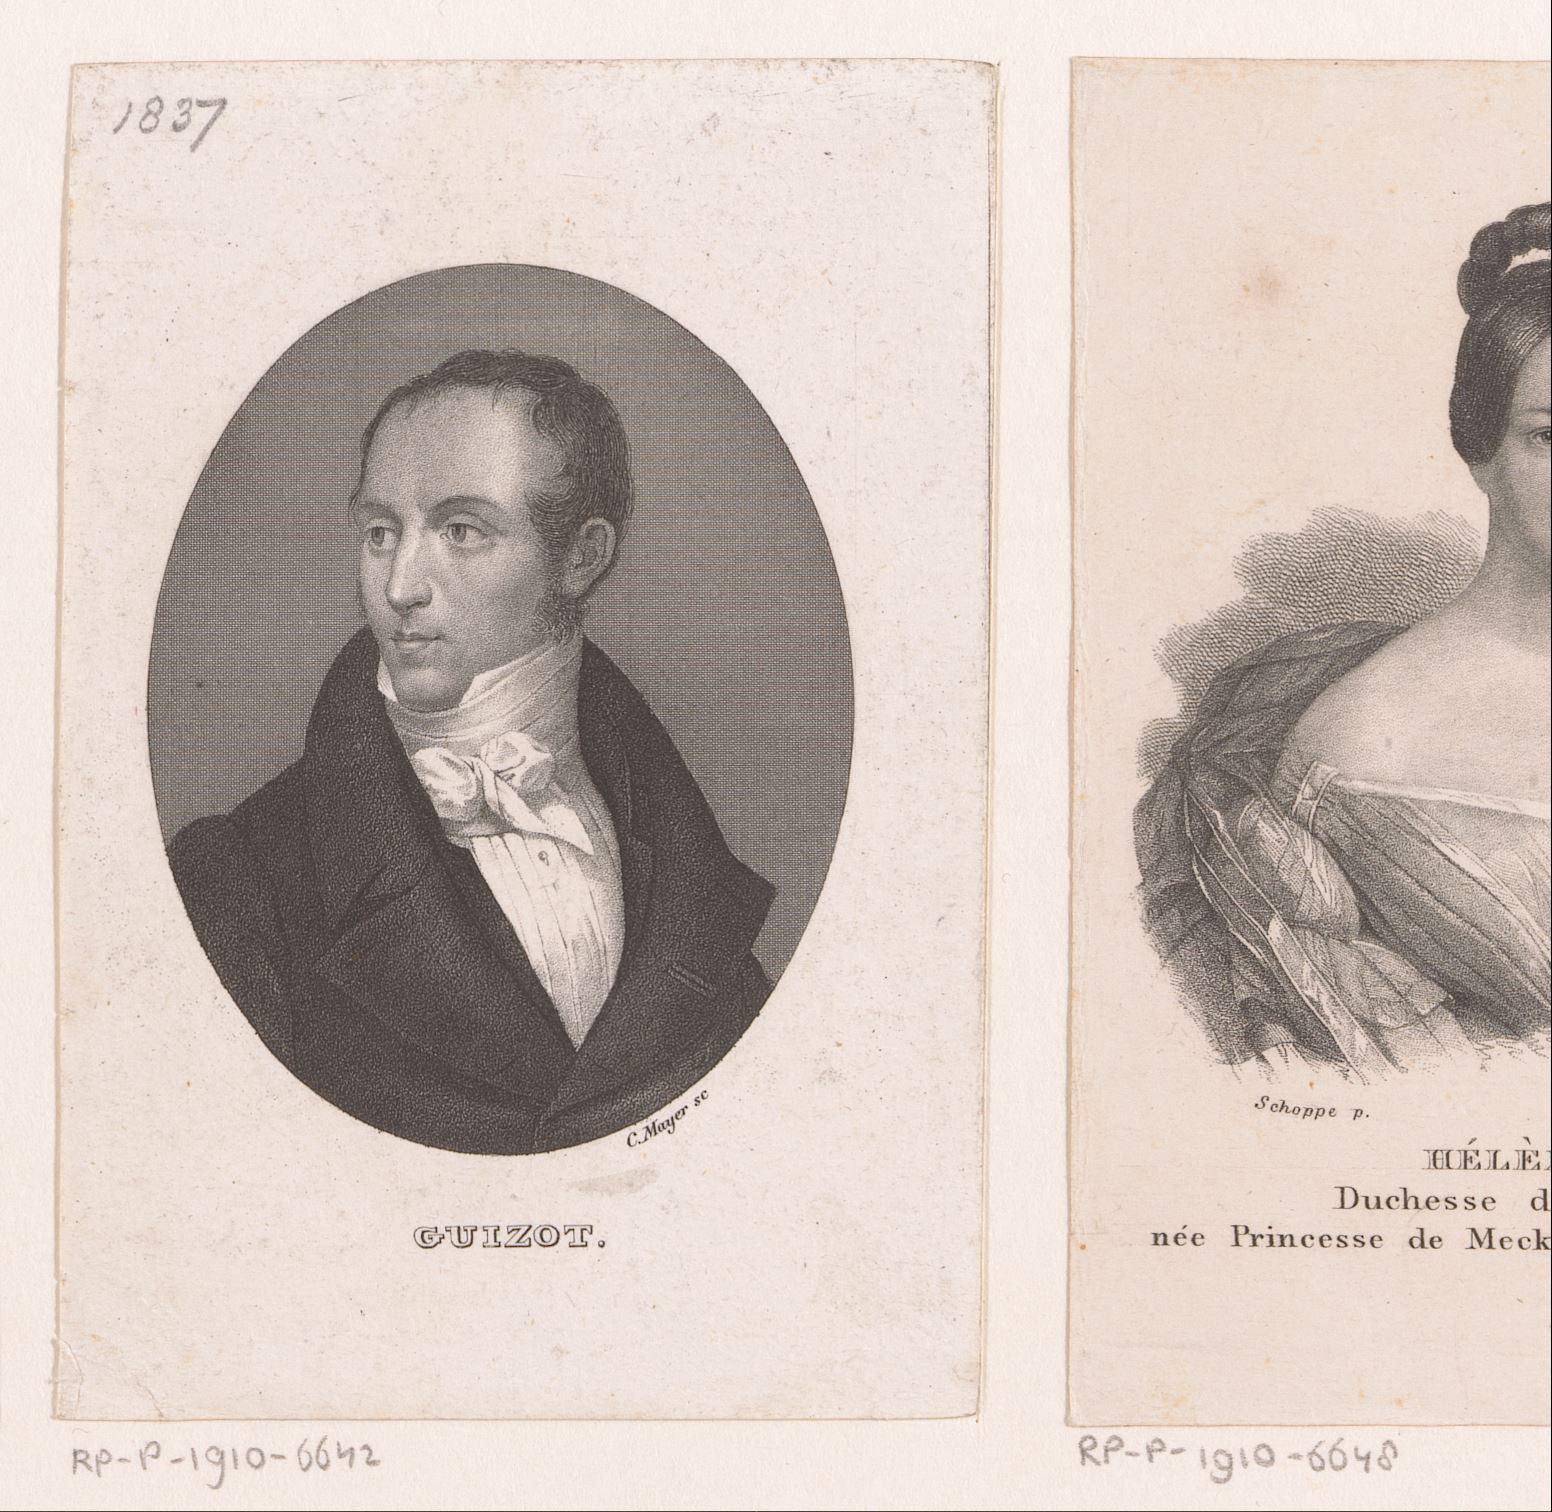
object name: print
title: Portret van François Guizot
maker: carl mayer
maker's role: print maker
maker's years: 1798-1868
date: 1808-1868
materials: paper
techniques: engraving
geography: nuremberg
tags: historical persons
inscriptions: collector's mark: Lugt 2228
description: Vermoedelijk afkomstig uit: Almanach de Gotha.